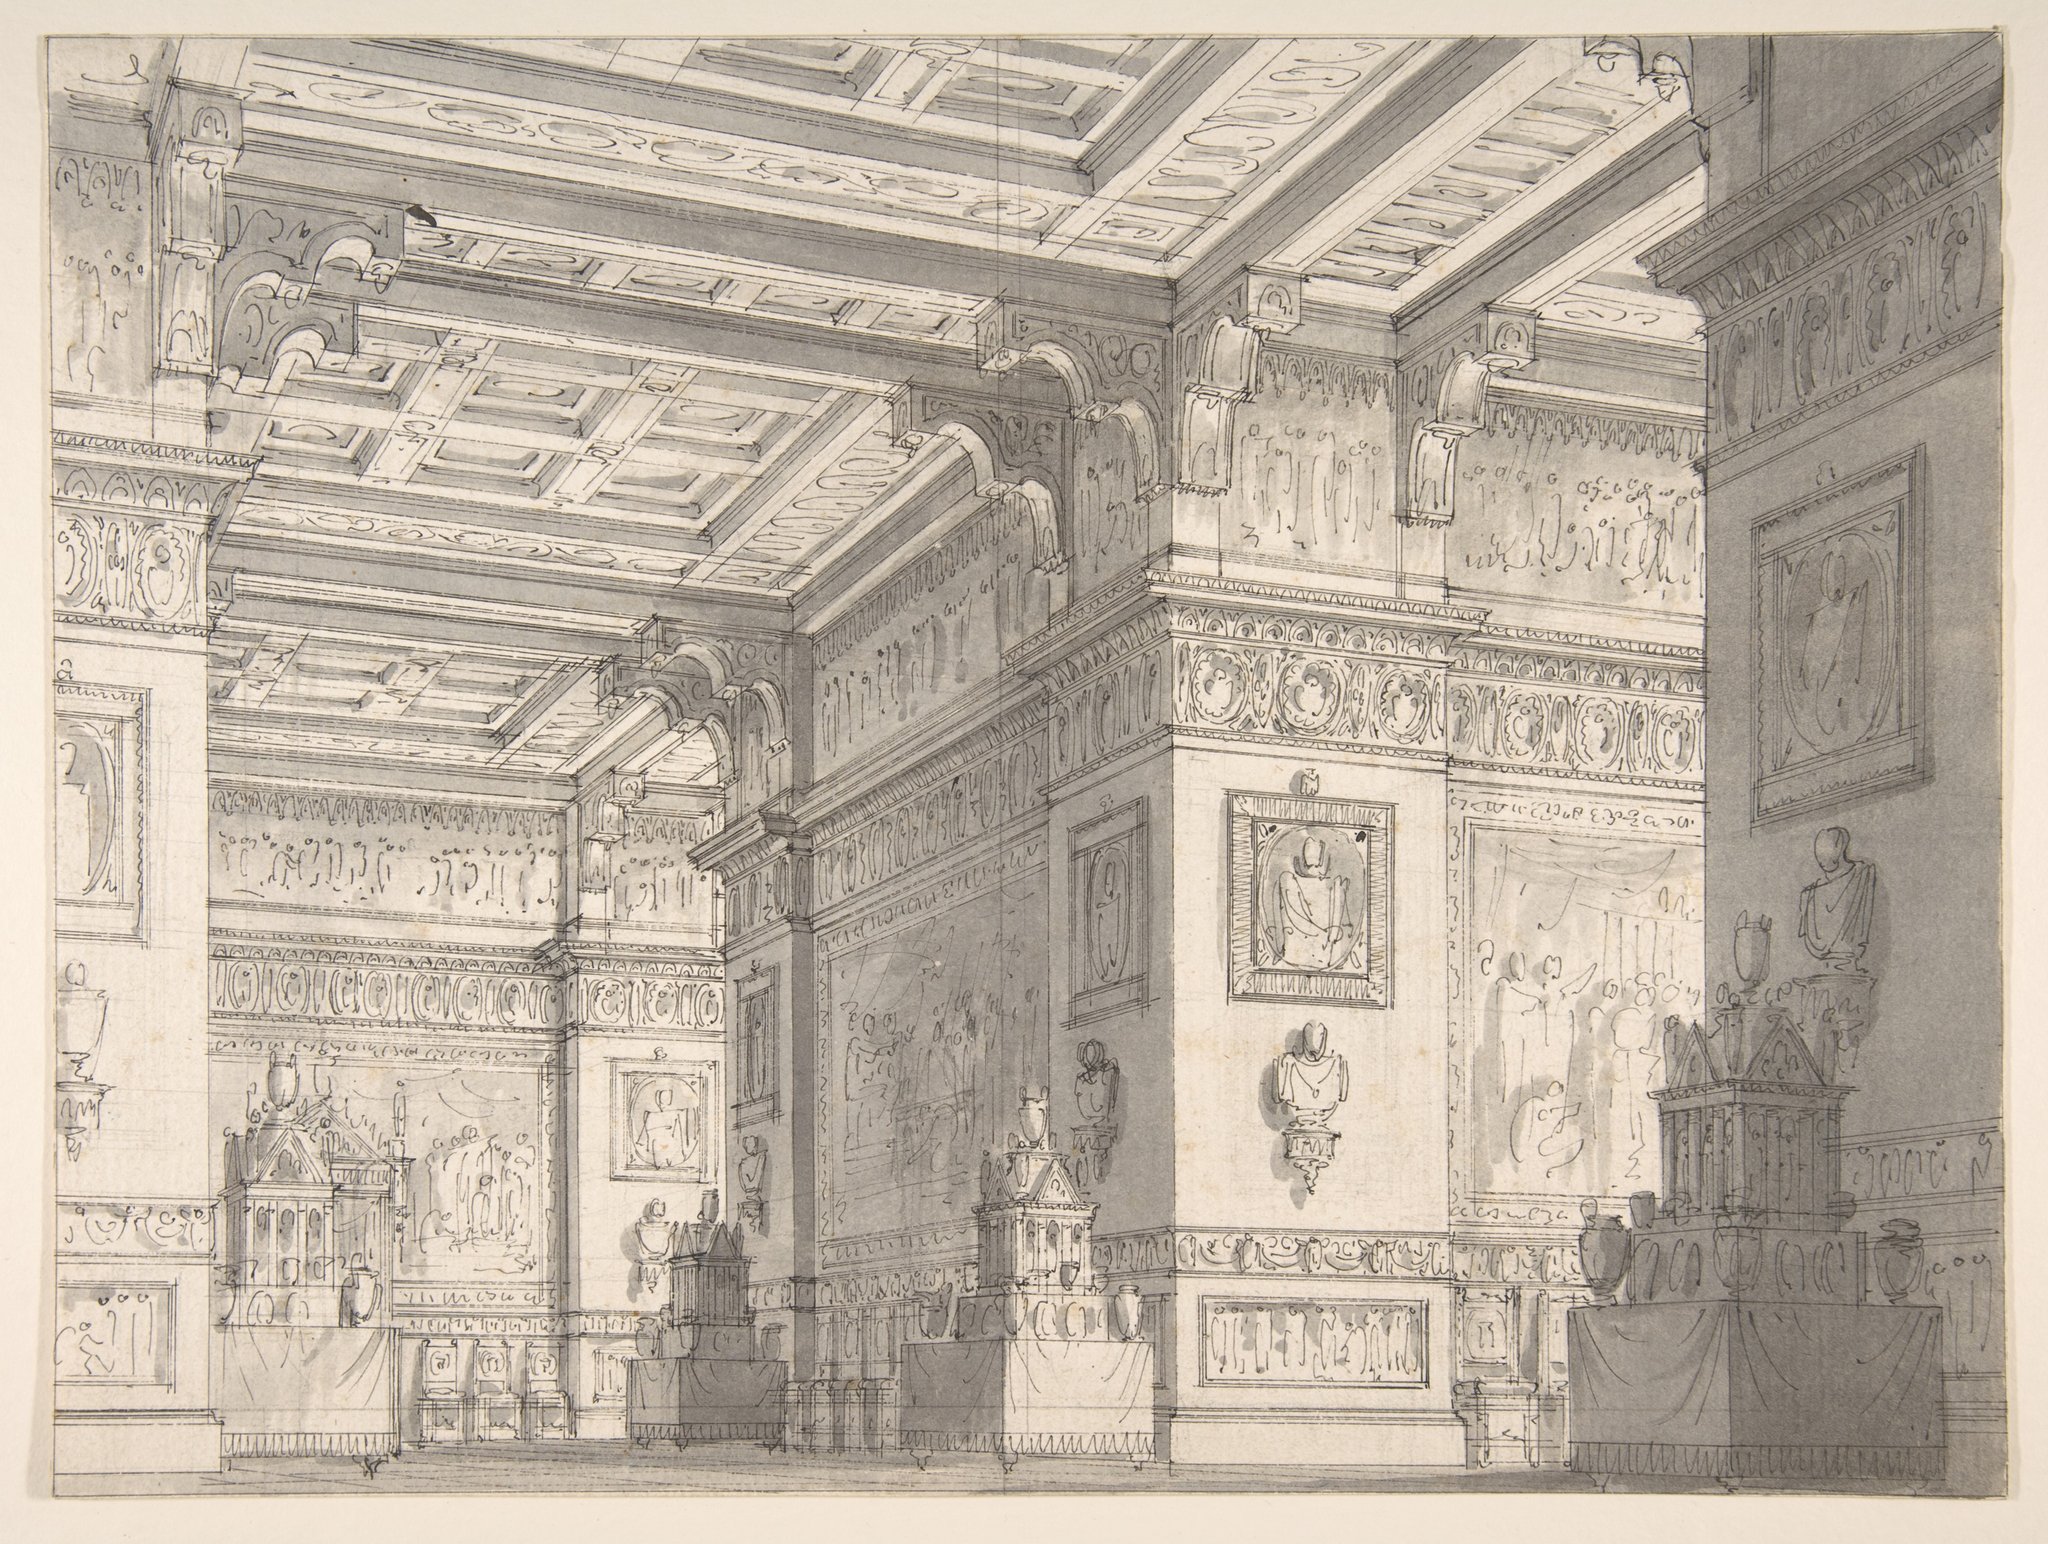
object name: drawing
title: Design for a Stage Set?:Interior of a Stateroom with Four Tables Displaying Urns and Tabernacles.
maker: alessandro sanquirico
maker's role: artist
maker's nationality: italian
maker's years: 1777-1849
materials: ink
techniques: brush, pen, wash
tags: interiors,stage design